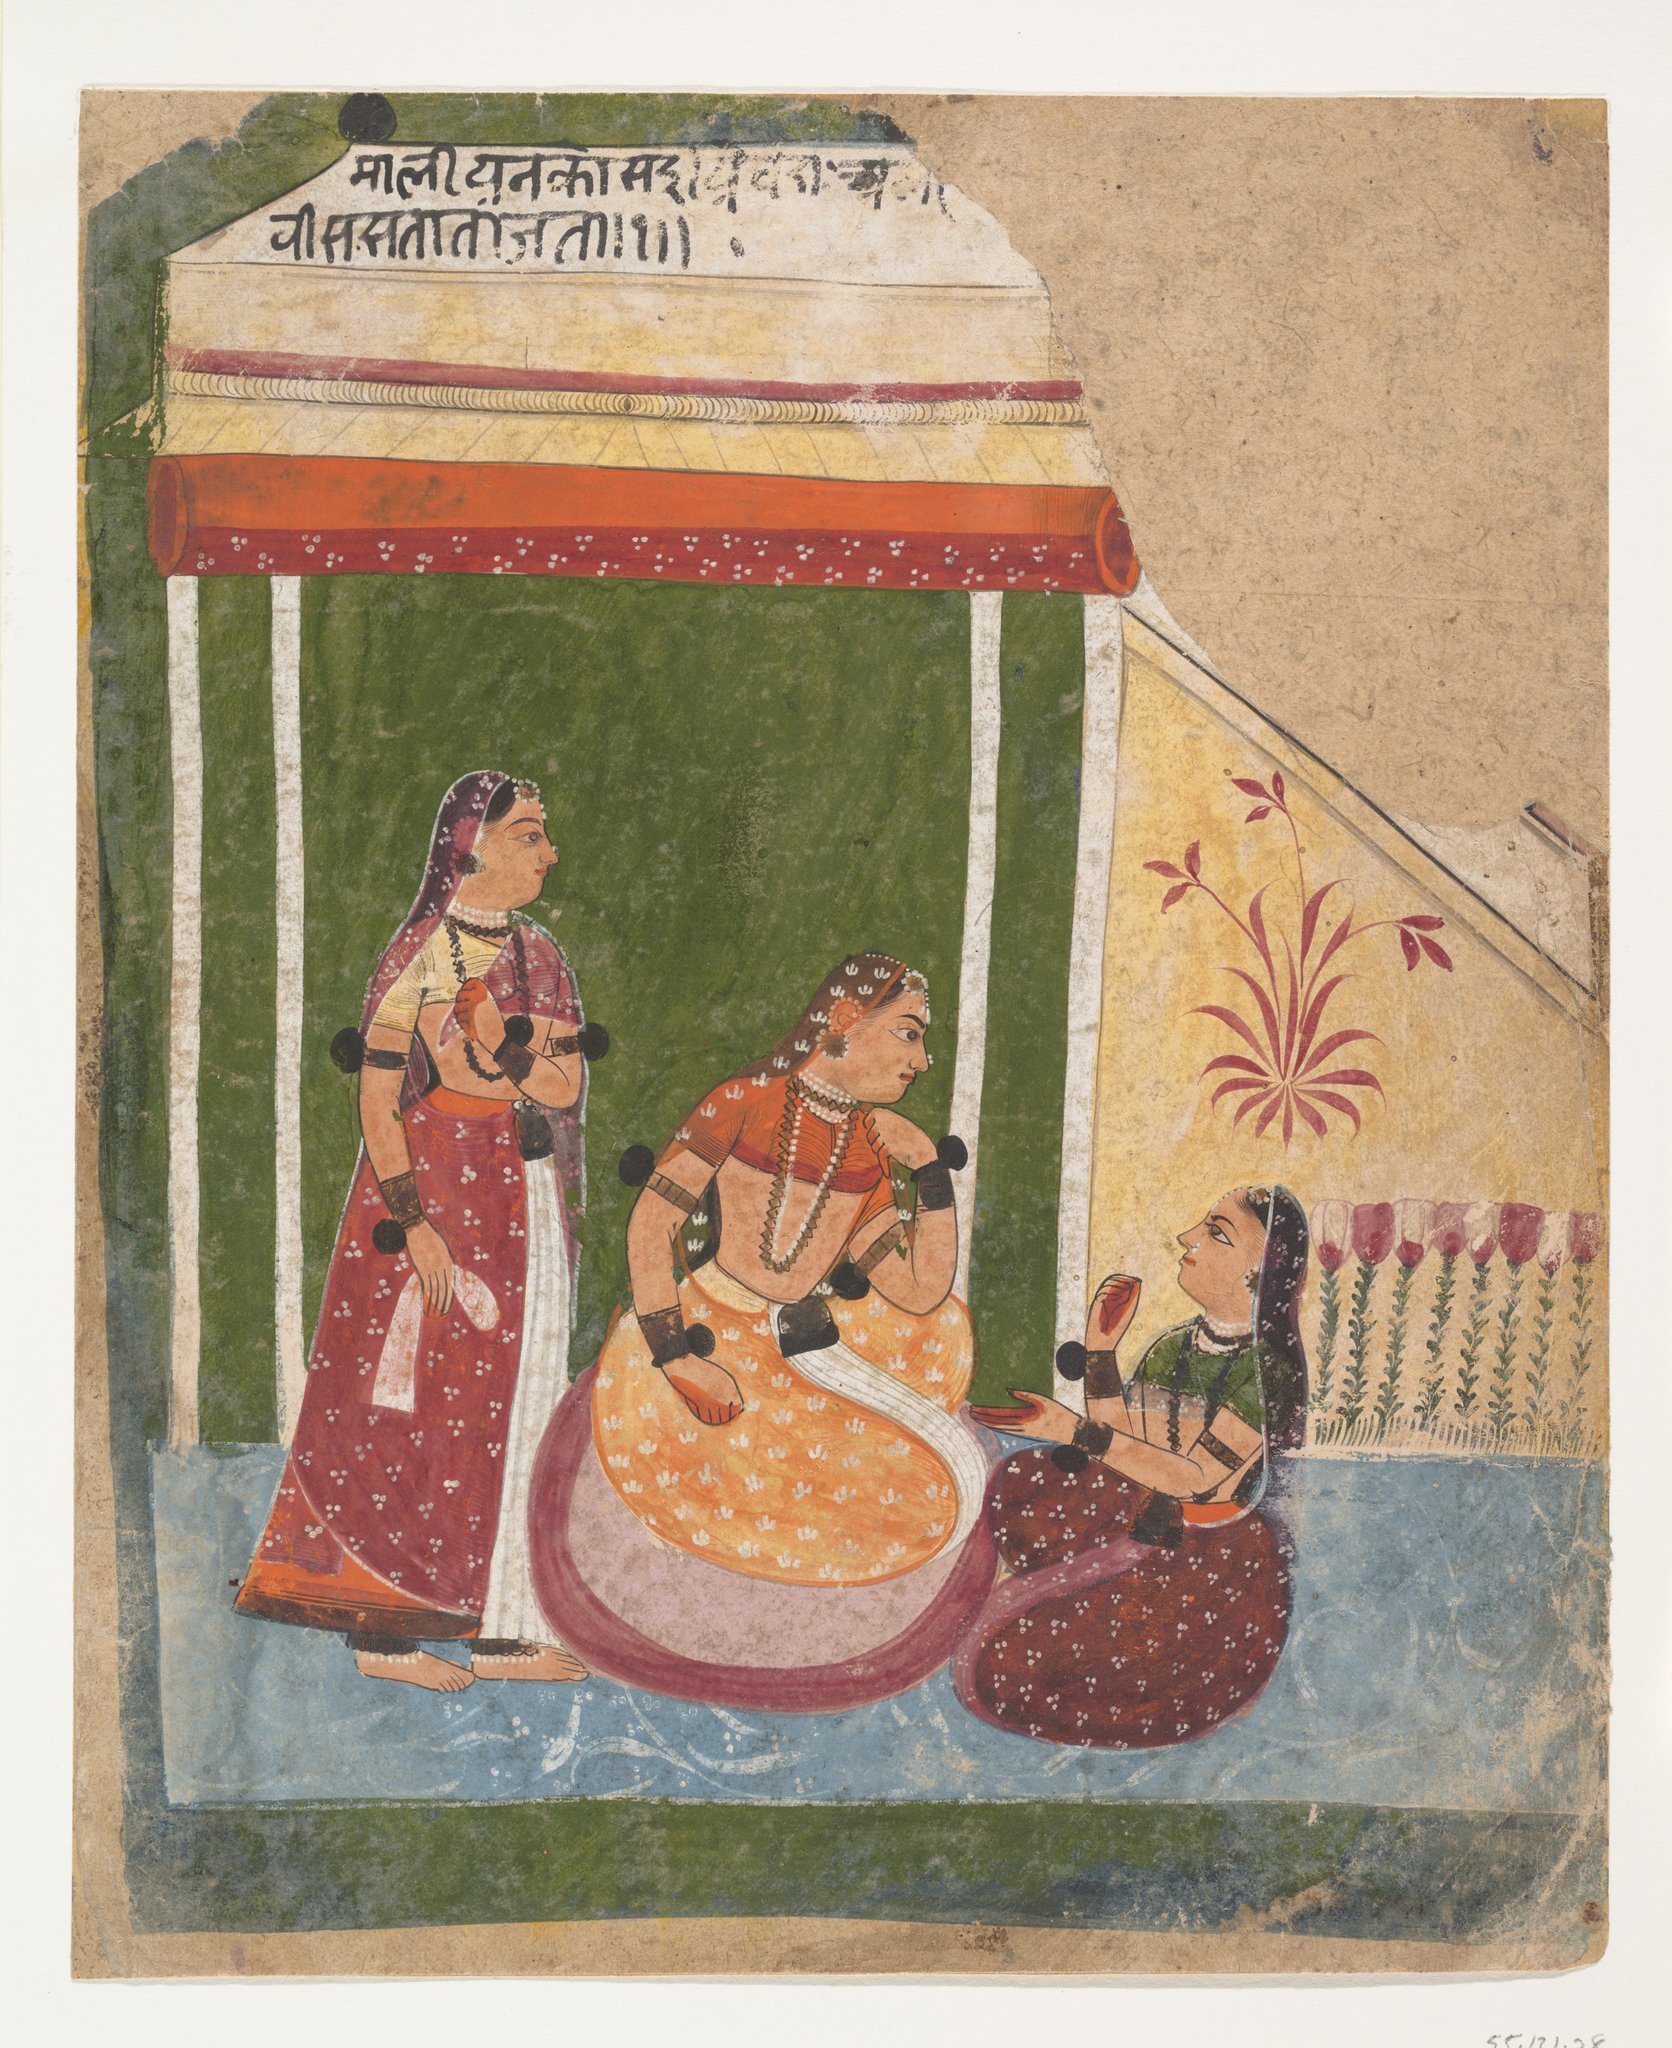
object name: folio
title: Ladies in a Pavilion: Page from a Dispersed Ragamala Series (Garland of Musical Modes)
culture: indian, rajasthan, marwar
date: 1640-1650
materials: ink, paper, watercolor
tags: women